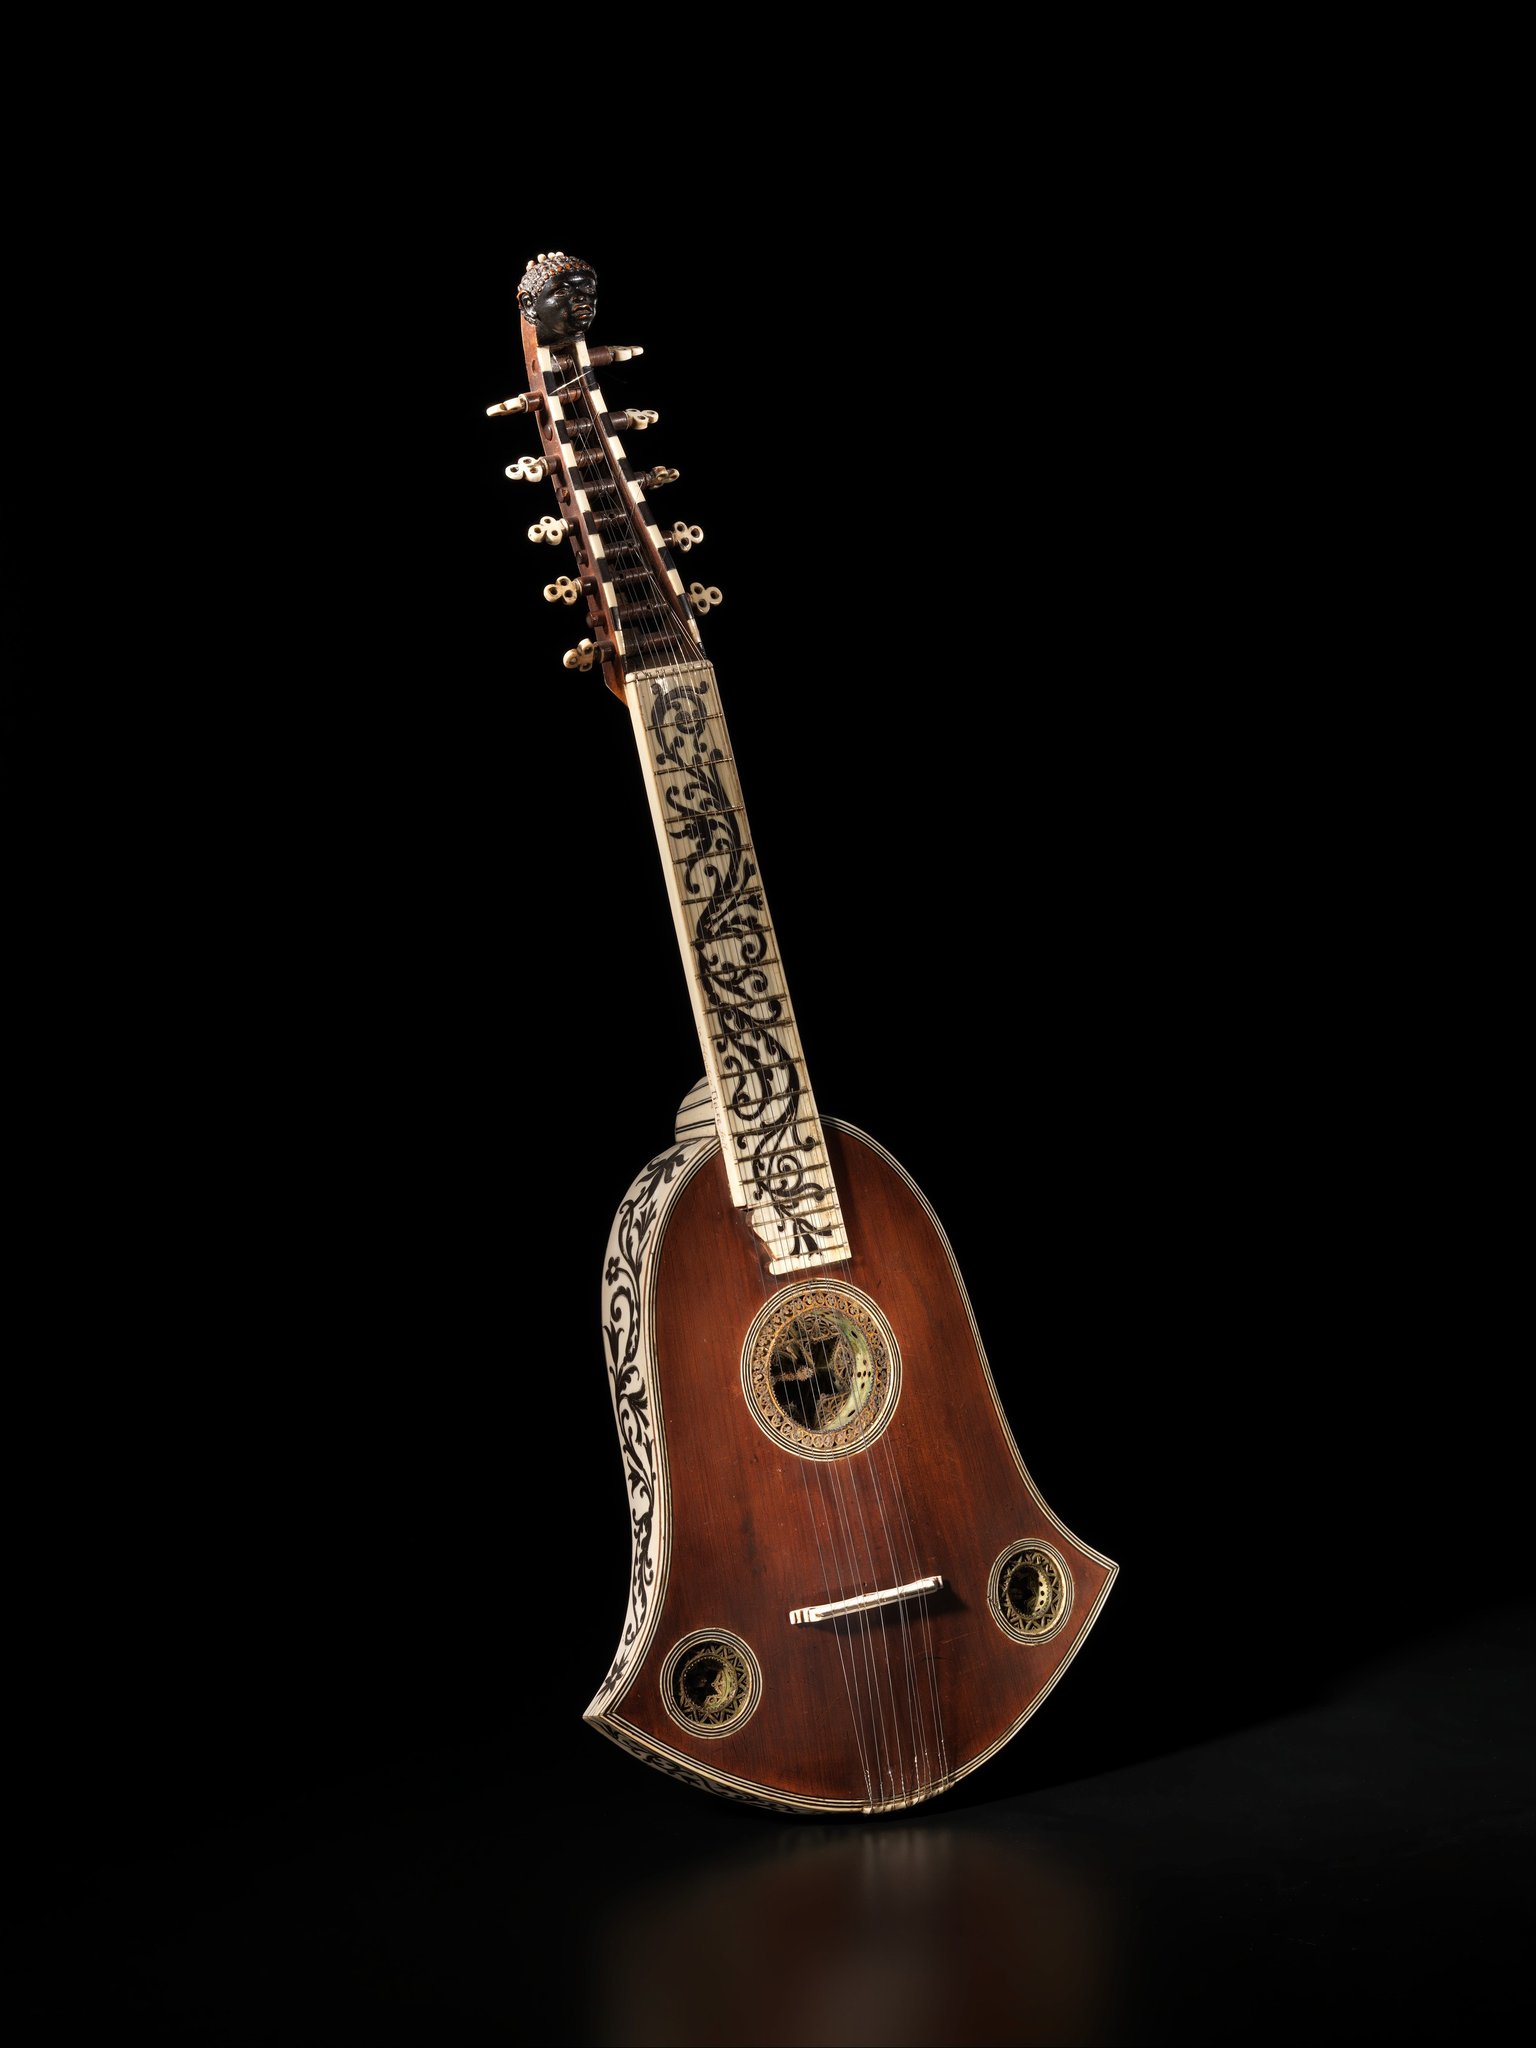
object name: cittern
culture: german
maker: joachim tielke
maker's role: maker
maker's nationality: german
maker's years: 1641-1719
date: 1685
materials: brass, wood, ivory, parchment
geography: germany